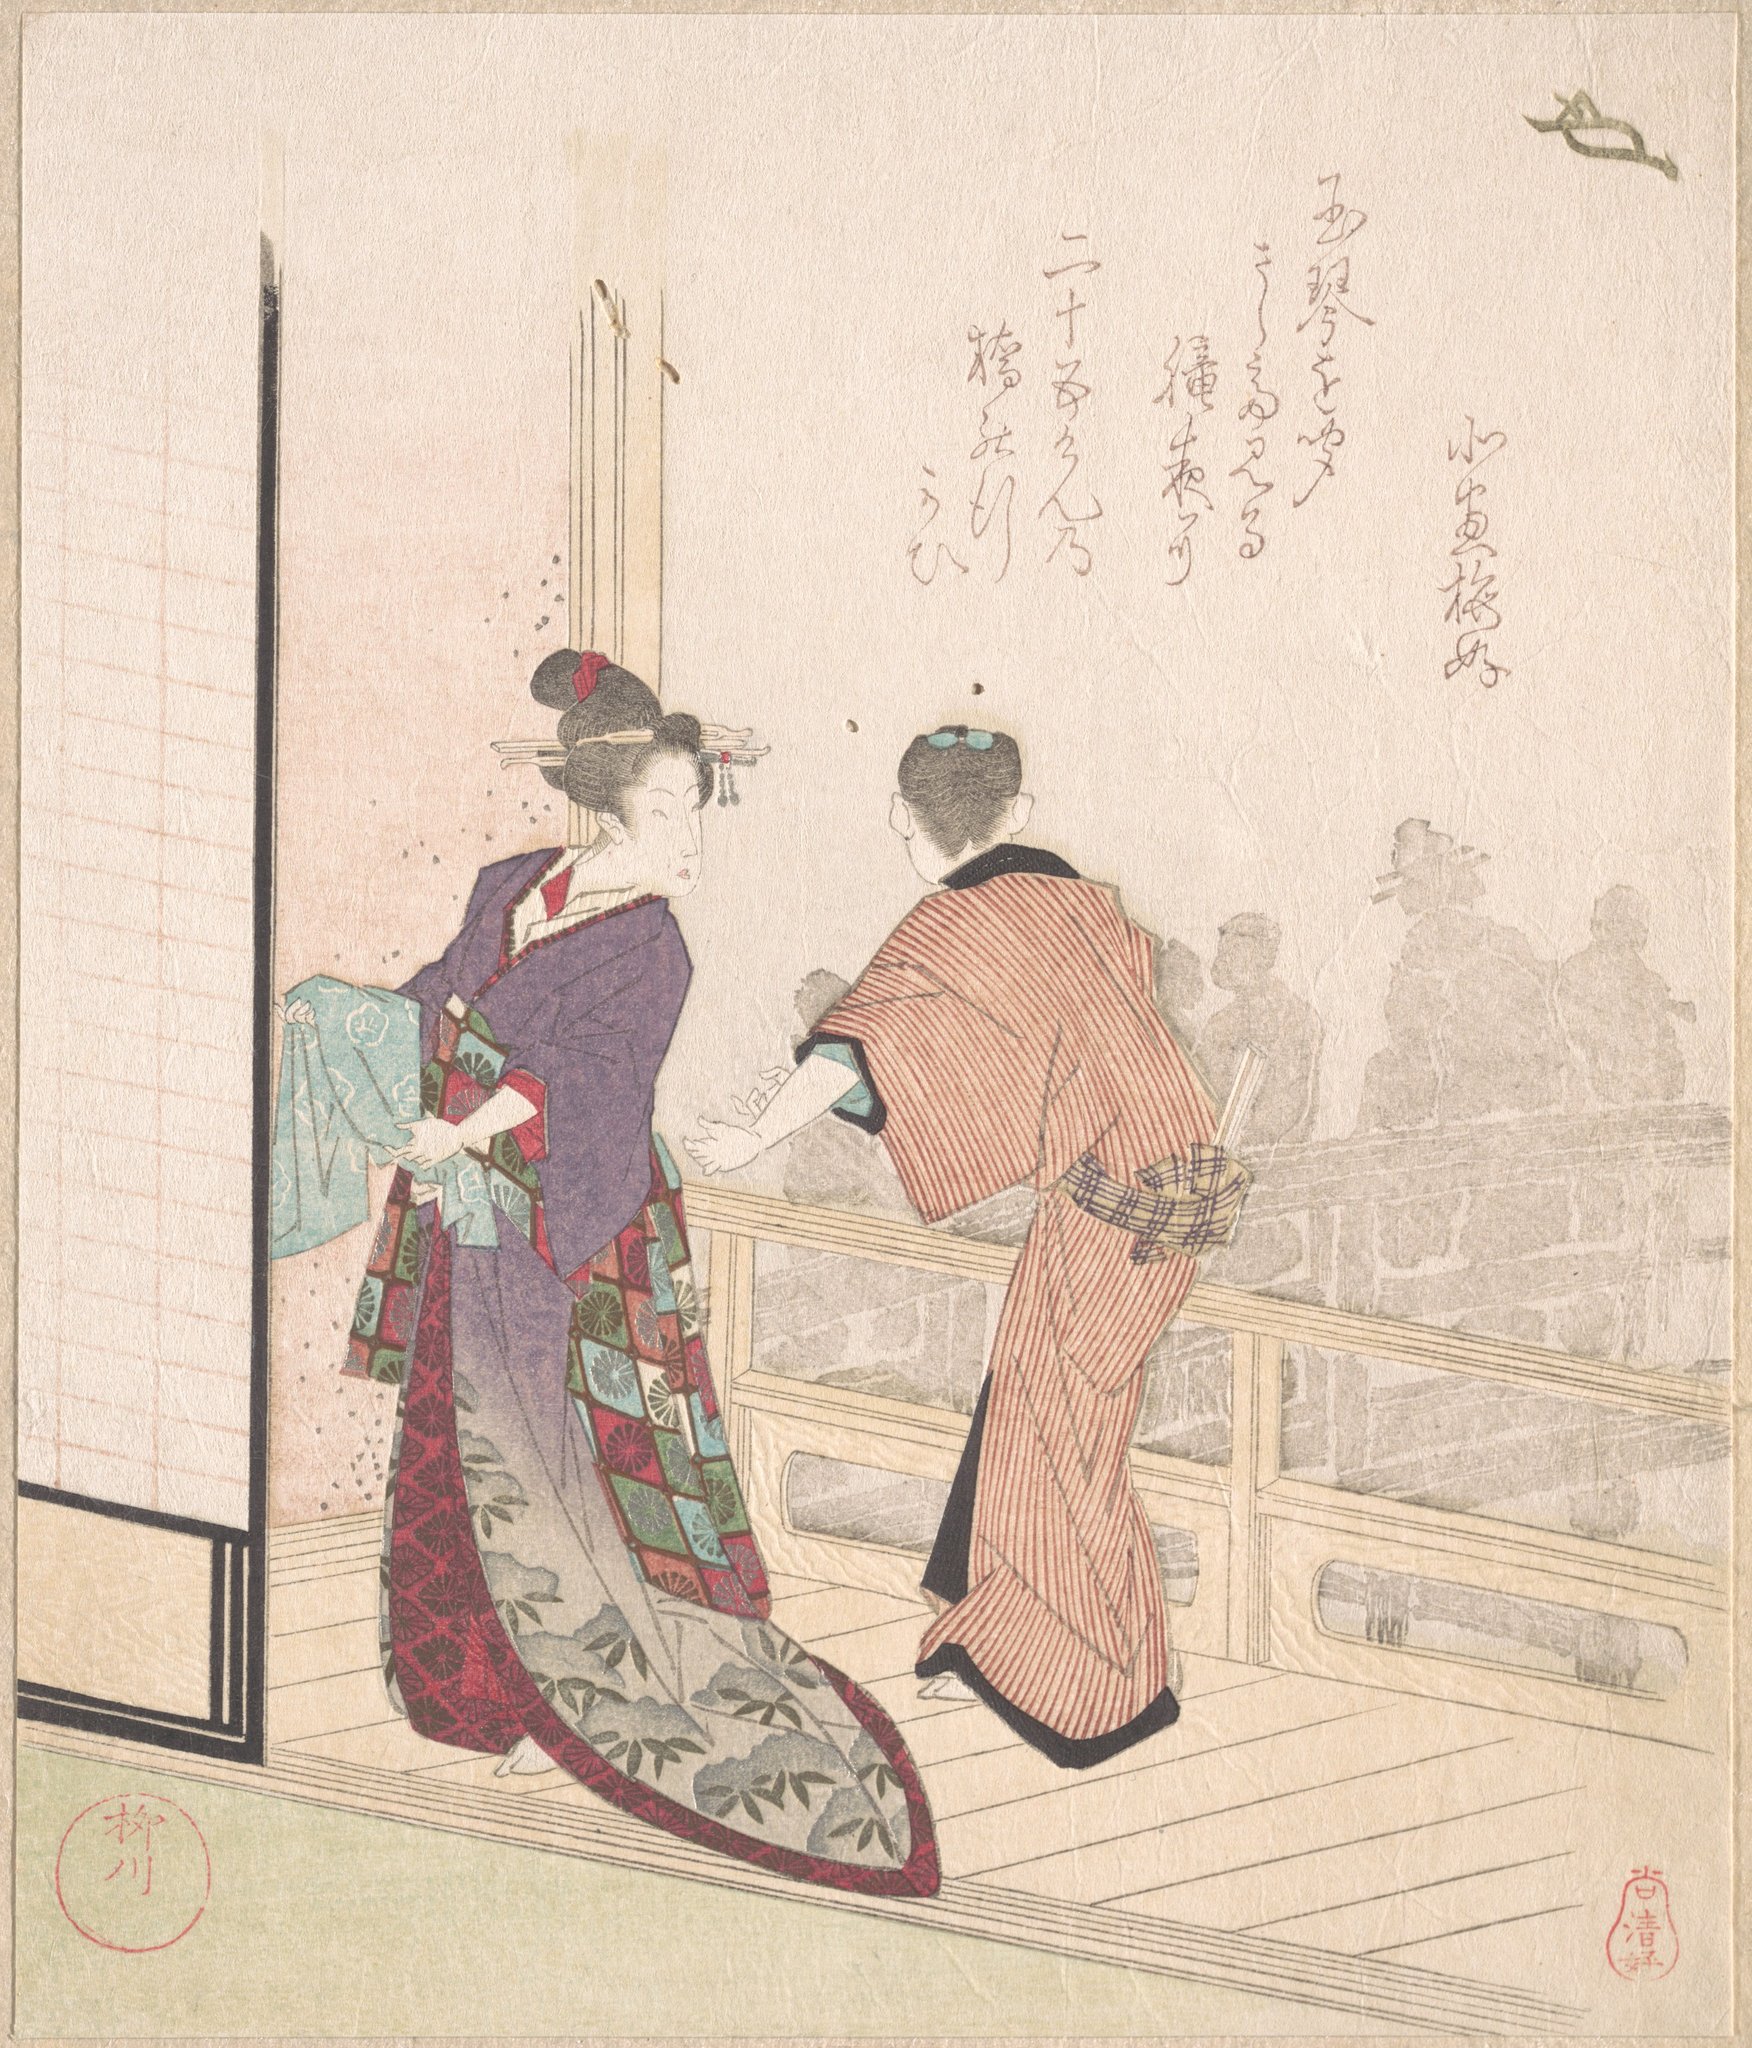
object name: print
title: Scene on the Veranda of a Teahouse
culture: japanese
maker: yanagawa shigenobu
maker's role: artist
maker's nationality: japanese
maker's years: 1787-1832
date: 1701-1900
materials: ink, paper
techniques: surimono, woodblock print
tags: women